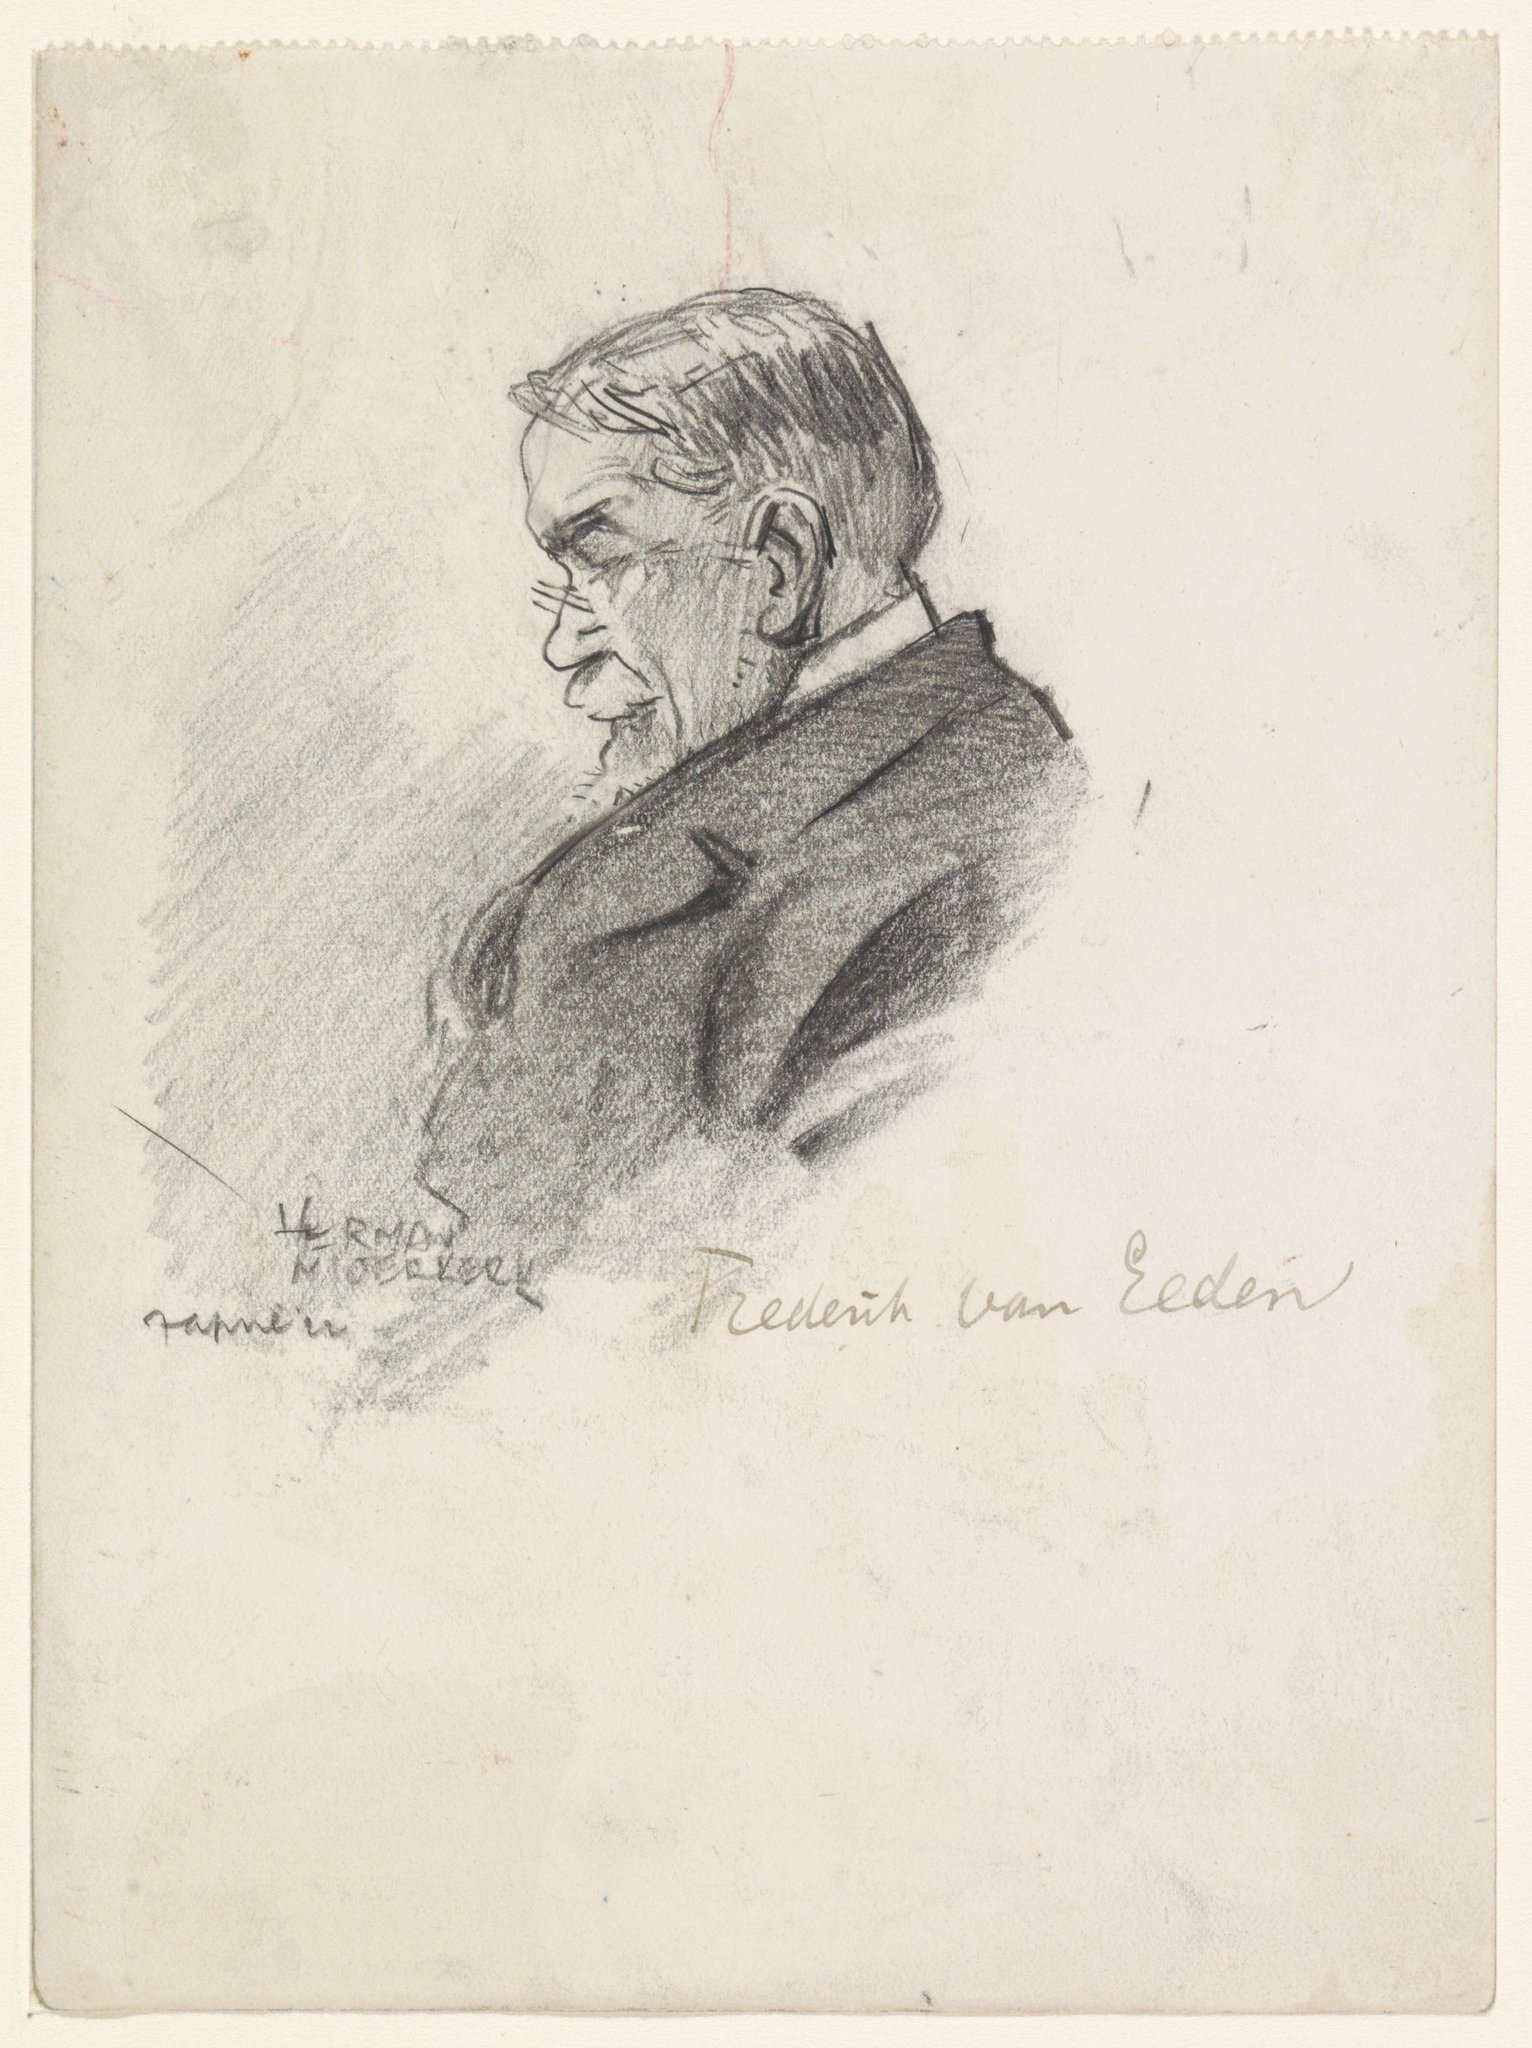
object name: drawing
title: Portret van de schrijver Frederik Willem van Eeden, op latere leeftijd, en profil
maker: willem moerkerk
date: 1880-1955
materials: chalk, paper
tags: haarlem, frederik van eeden, historical persons, portrait of a writer, portrait, self-portrait of artist